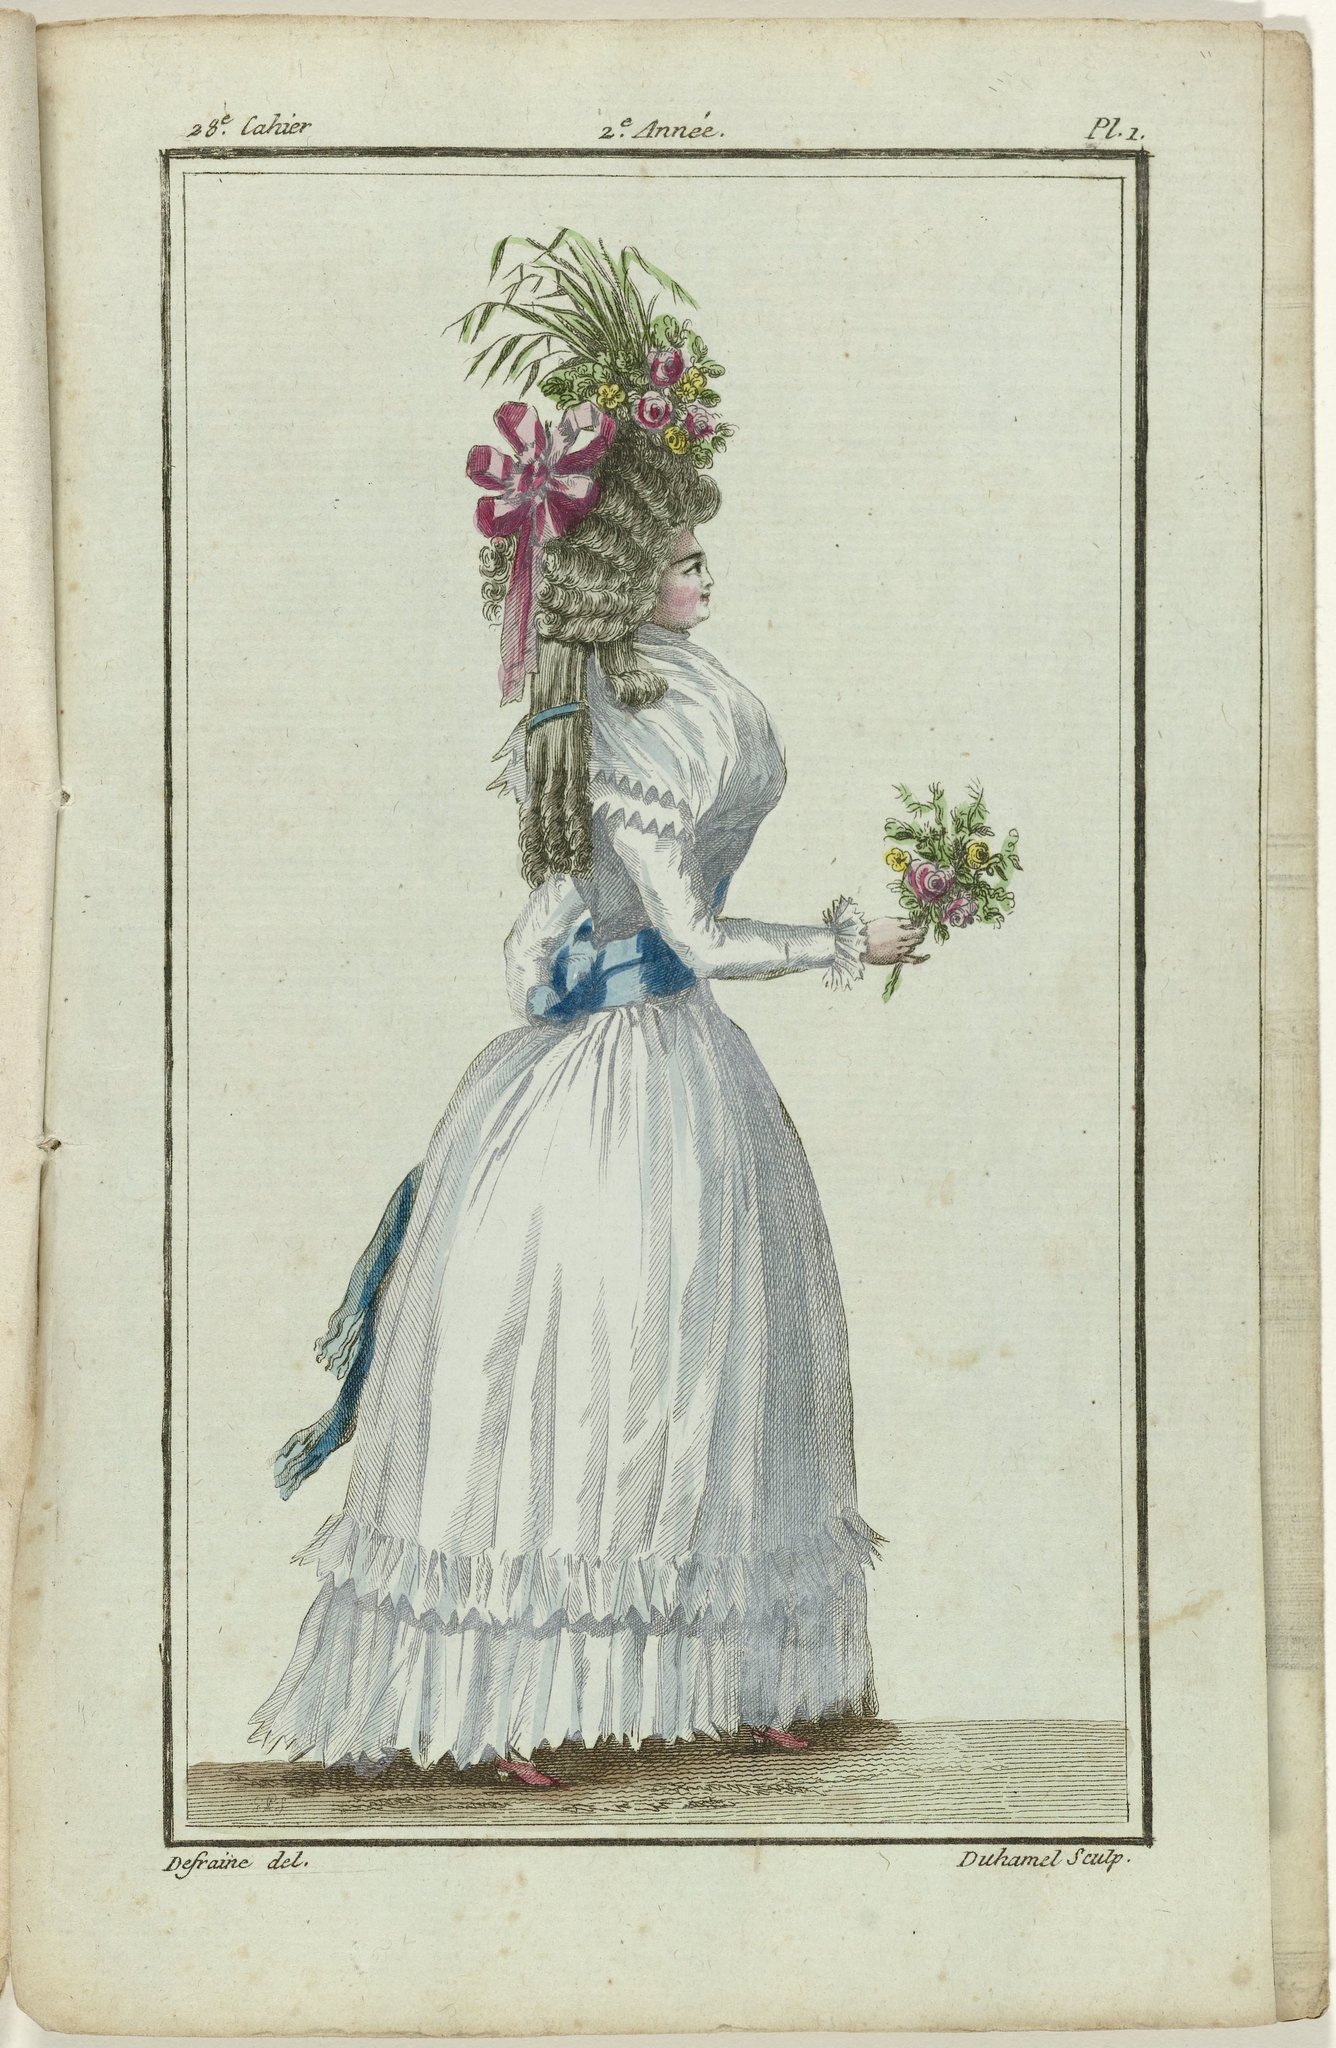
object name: fashion print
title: Magasin des Modes Nouvelles Françaises et Anglaises, 20 août 1787, 2e Année, 28e cahier, Pl. 1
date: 1787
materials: paper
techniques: engraving, hand coloring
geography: paris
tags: dress, gown (fourreau) (+ women's clothes), head-gear (+ women's clothes), fashion plates, flowers: rose, piece of clothing covering the breast or décolleté (fichu) (+ women's clothes), belt, girdle, waistband (+ women's clothes)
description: Vrouw, op de rug gezien, gekleed in een ´fourreau´ van wit linnen met falbalas. Om de hals een fichu. Om het middel een blauw ceintuur. Boeket rozen in rechterhand. De prent maakt deel uit van het 28e Cahier uit de serie Magasin des Modes Nouvelles Françaises et Anglaises. De serie bestaat uit 172 modeprenten, uitgegeven door Buisson, Parijs, 20 november 1786 - 21 décembre 1789